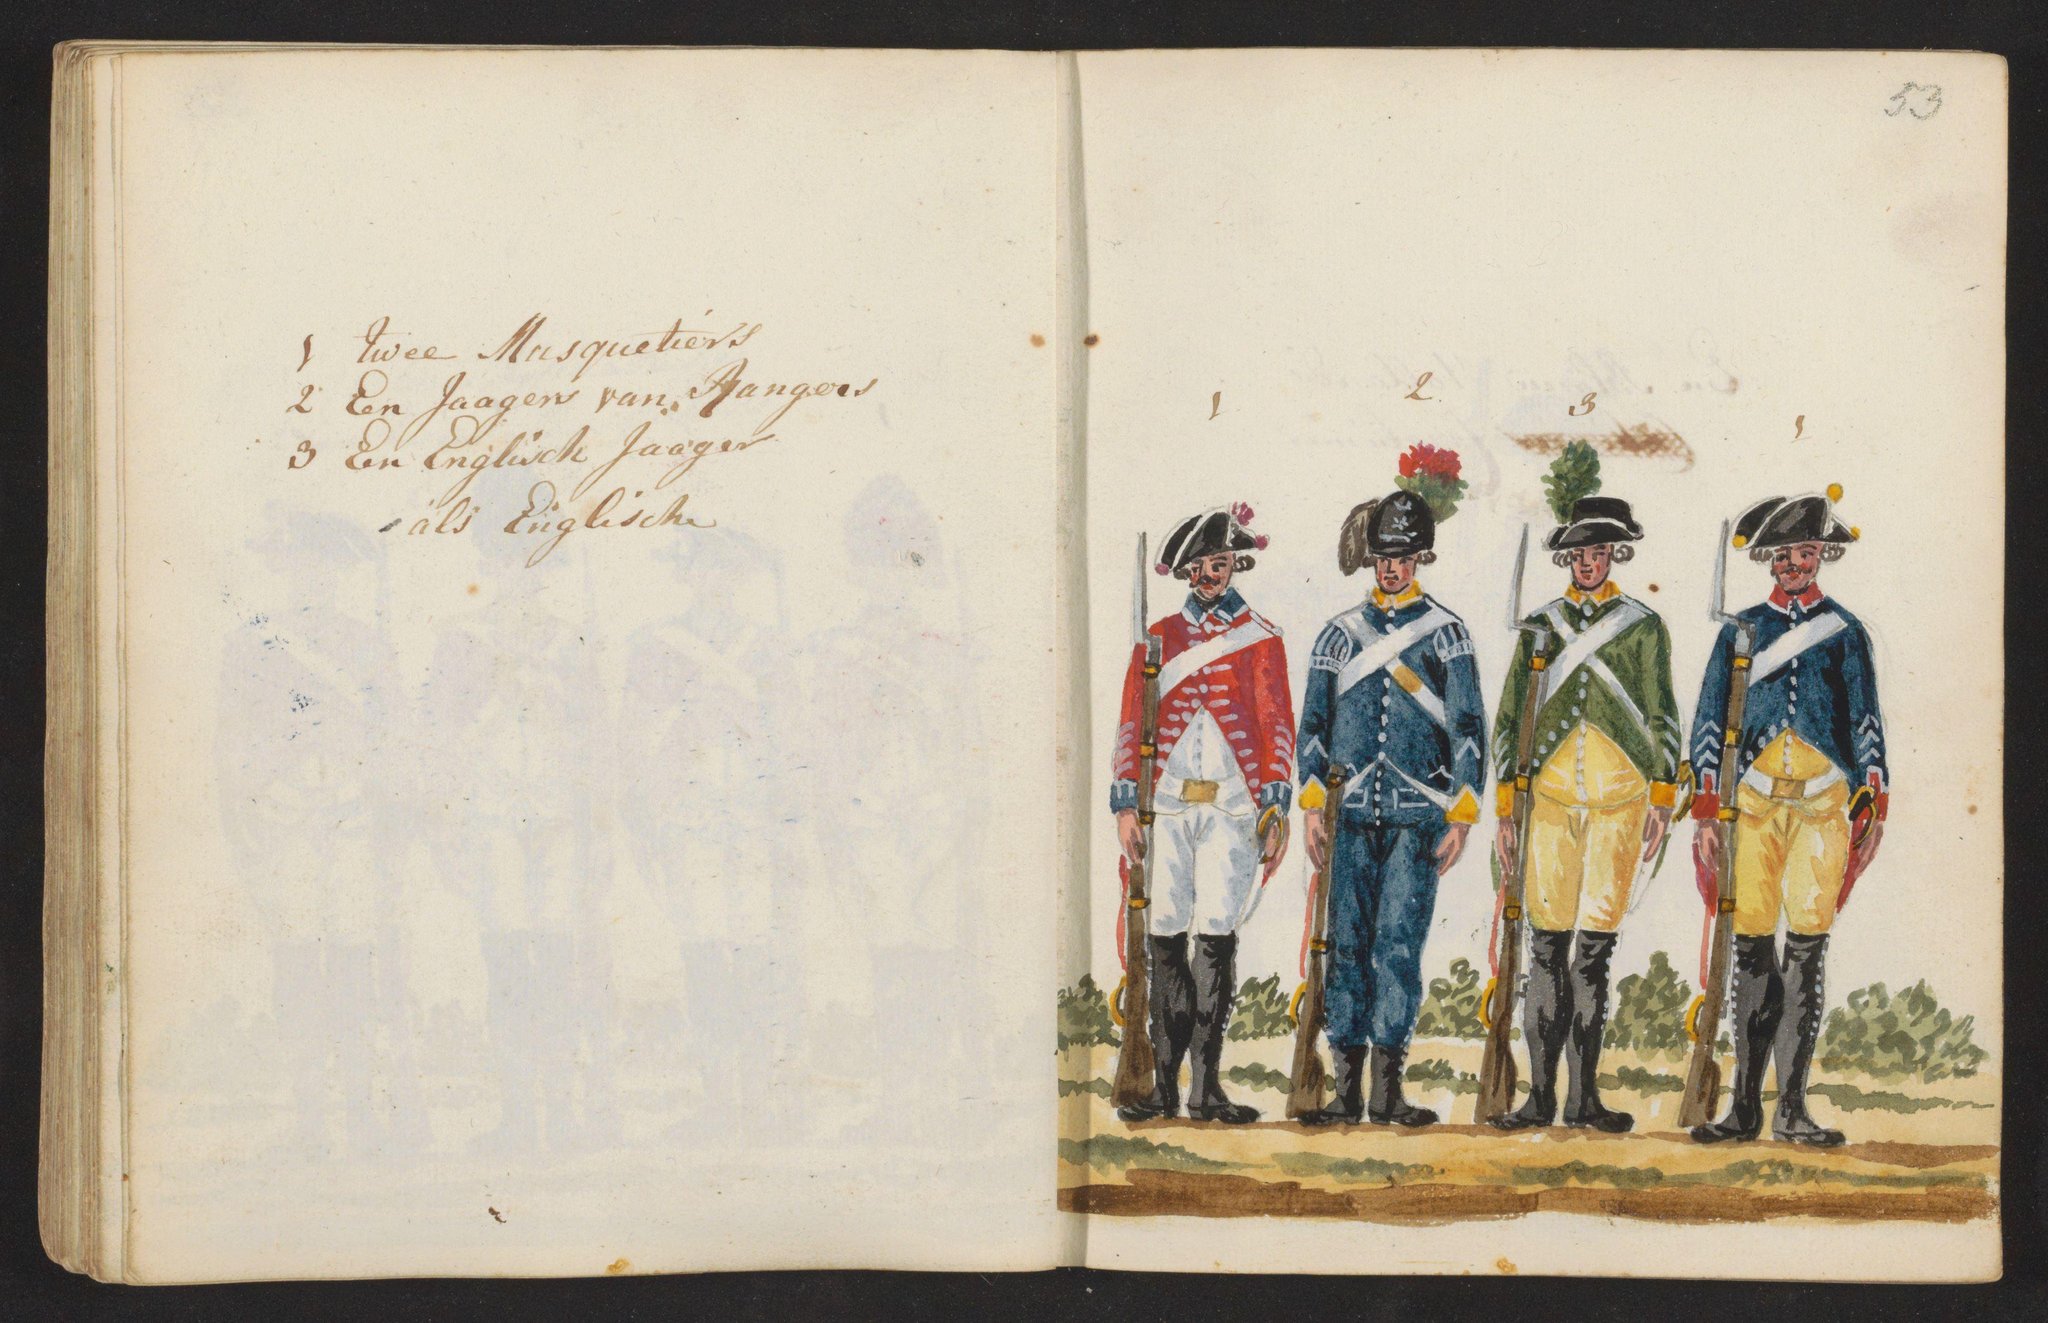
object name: drawing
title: Uniformen van Engelse soldaten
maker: s.g. casten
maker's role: draughtsman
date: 1795-1796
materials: paper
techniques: writing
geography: amsterdam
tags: (military) uniforms (+ cavalry, horsemen), patriots (1780-1795)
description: Uniformen van vier Engelse soldaten, ca. 1788-1795. Twee musketiers, een jager van de Rangers en een geewone jager. Onderdeel van het derde hoofdstuk over de nieuwe uniformen in de periode na het herstel van de prins van Oranje en de komst van de Pruisische troepen in Holland in 1787. In het schetsboek met gekleurde tekeningen van de uniformen van militairen en leden van de schutterij uit de periode 1770 tot 1795-1796.